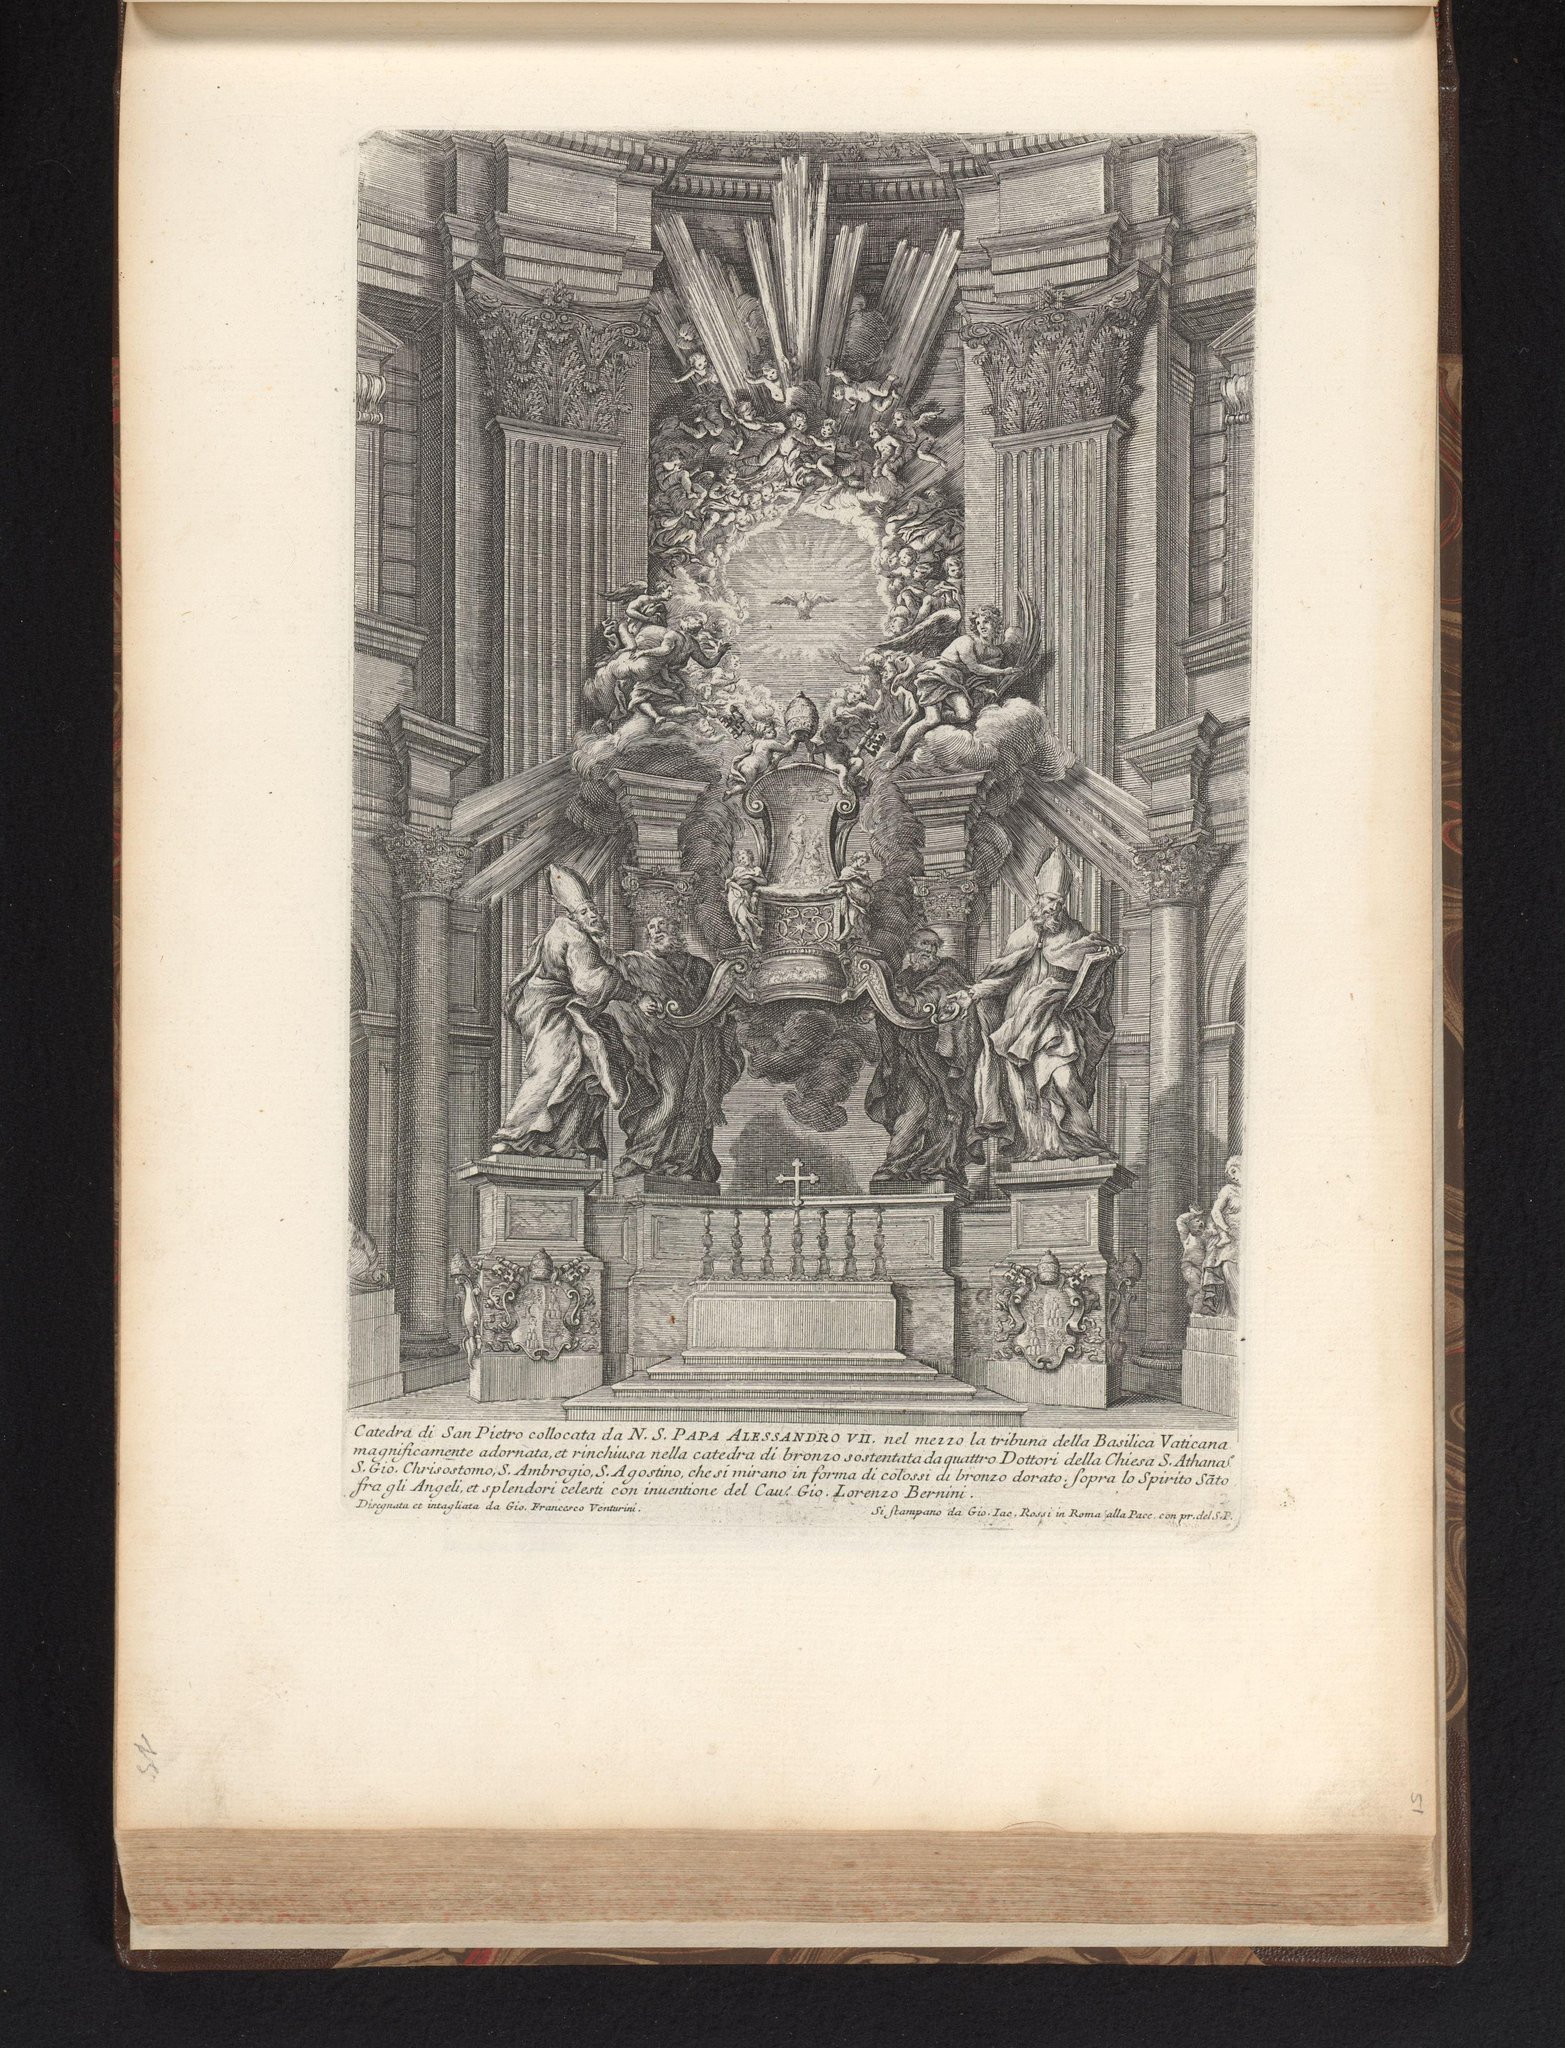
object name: album leaf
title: Il nuovo teatro di Roma moderna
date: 1665-1667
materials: paper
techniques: etching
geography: rome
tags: interior of church, piece of sculpture, reproduction of a piece of sculpture, bishop's throne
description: De Cathedra Petri, het altaar waarin het reliek van de katheder van de apostel Petrus wordt bewaard achter in de Sint-Pietersbasiliek in Vaticaanstad. Aan weerszijden van de stoel staan twee beelden van de kerkvaders. Tekst in het Italiaans in de ondermarge. Prent maakt deel uit van een album.